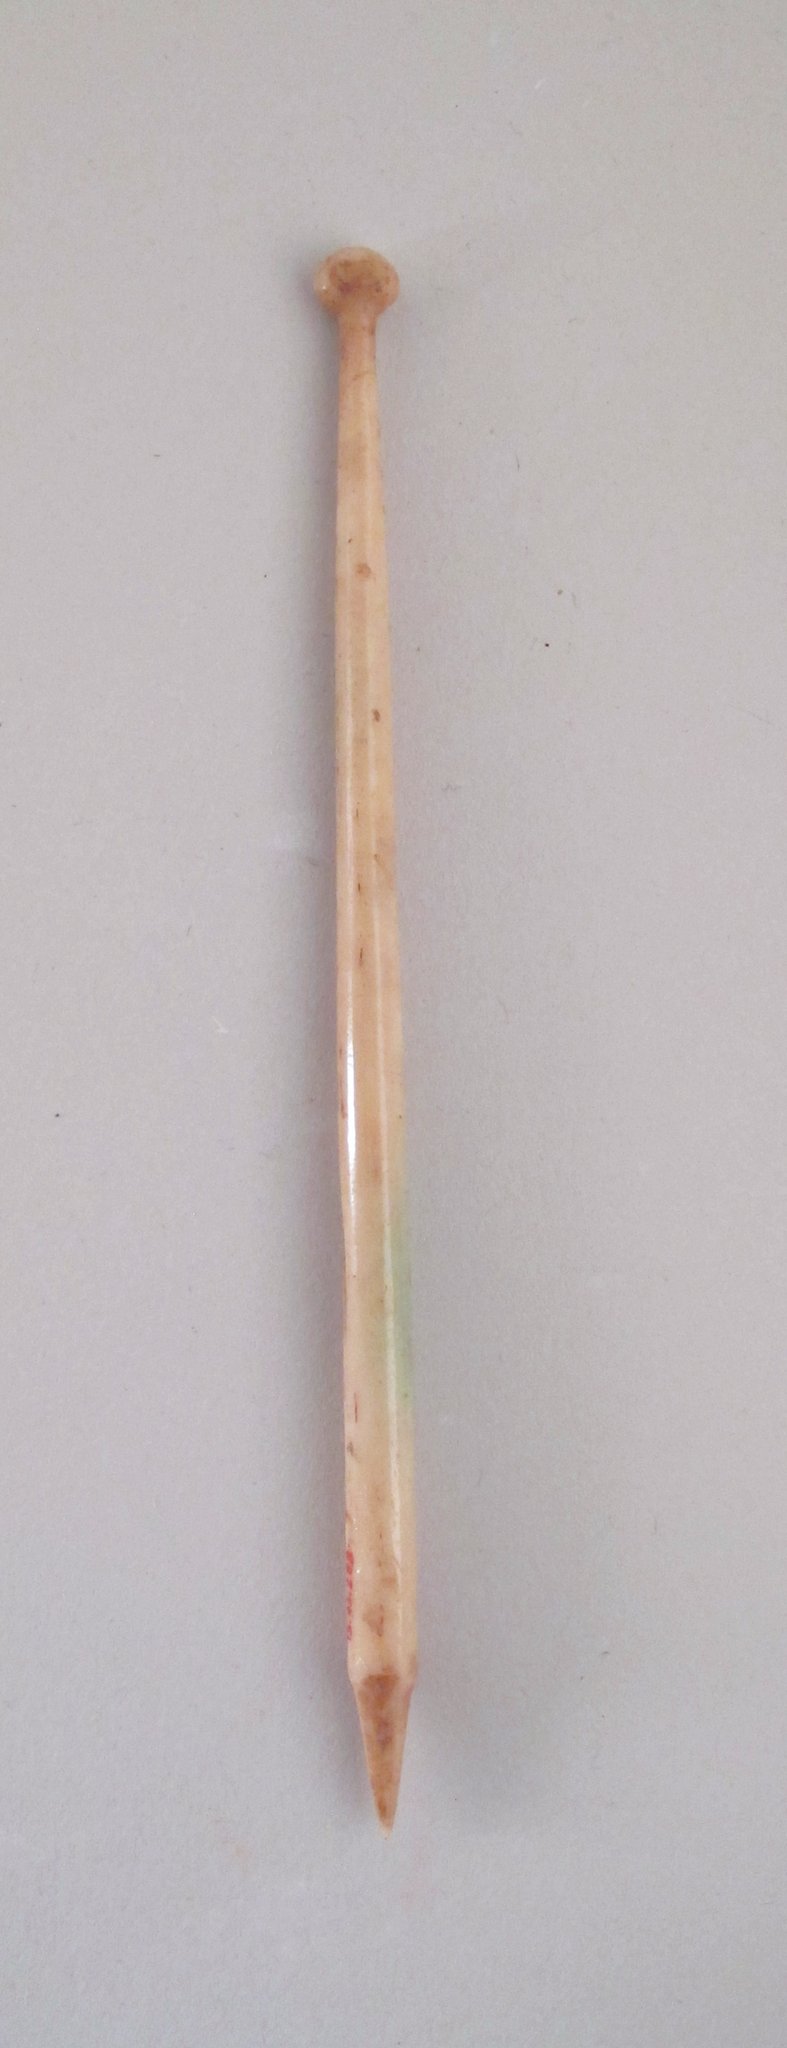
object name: awl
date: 7000 BCE-330 CE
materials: ivory